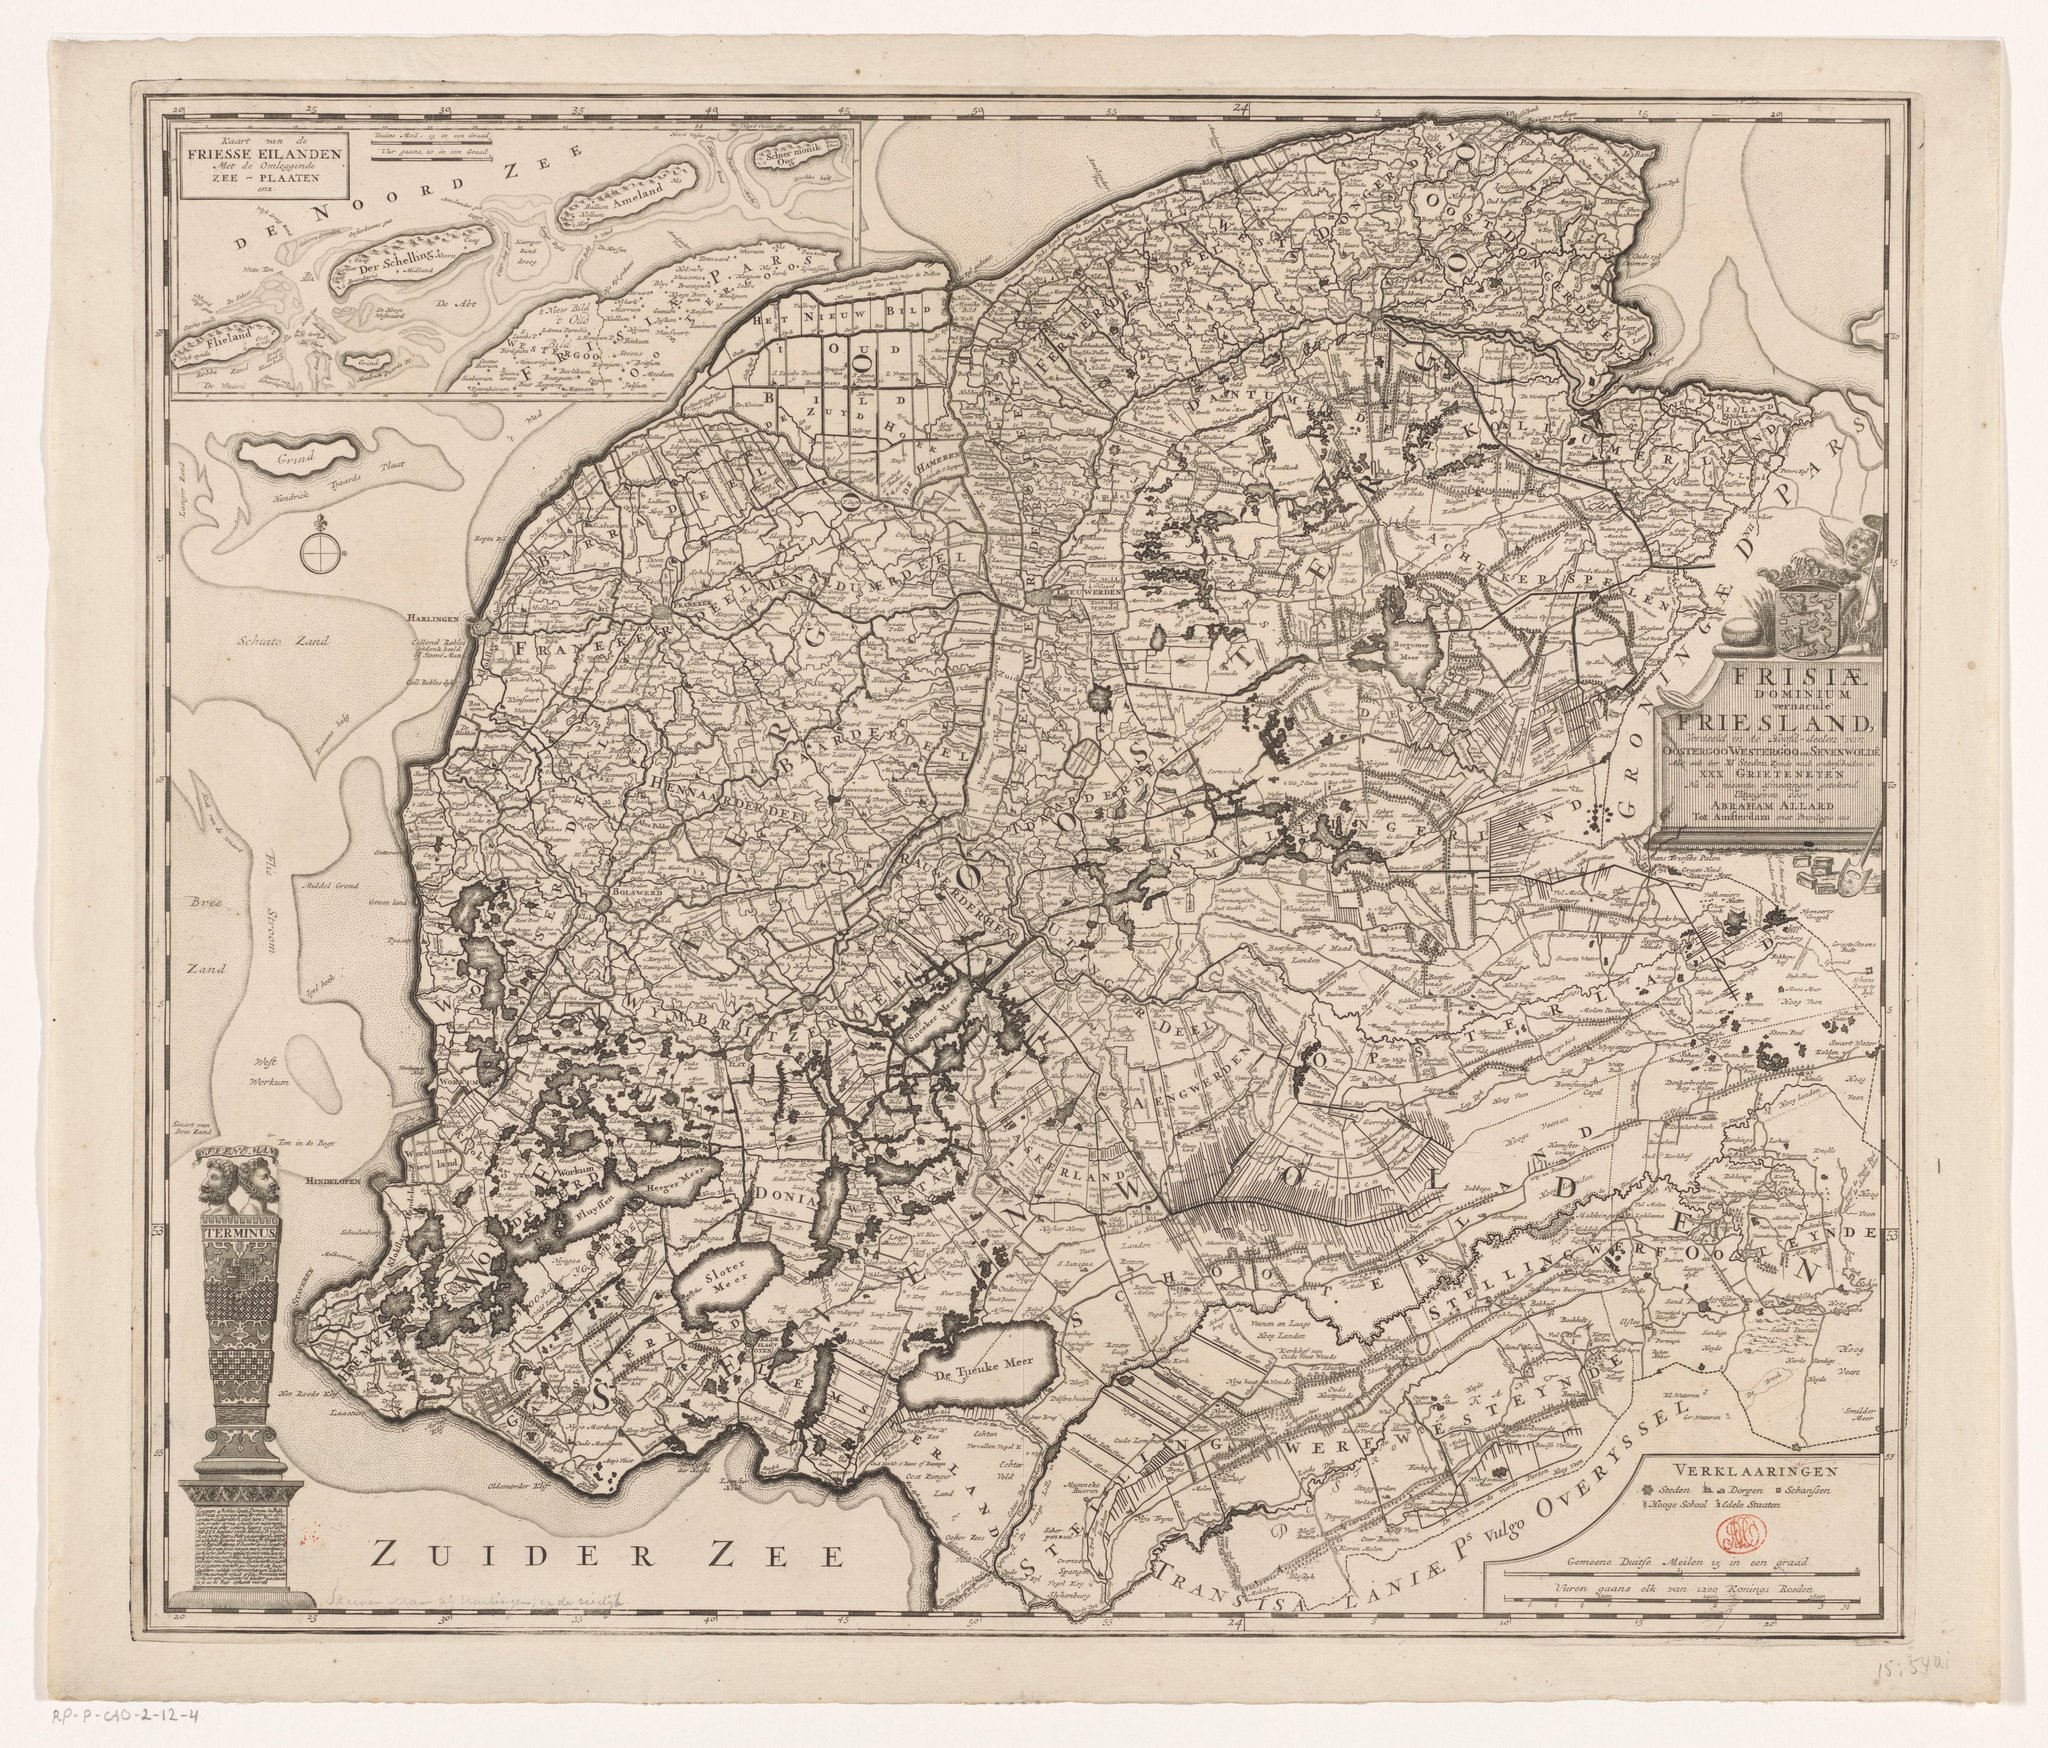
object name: print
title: Kaart van Friesland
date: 1703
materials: paper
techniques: engraving, etching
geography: amsterdam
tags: coat of arms (as symbol of the state, etc.), maps of separate countries or regions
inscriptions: collector's mark: Lugt 195, collector's mark: Lugt 2228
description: Linksboven inzetkaart van Vlieland, Terschelling, Ameland en Schiermonnikoog, met twee schaalstokken: Duitze meil 15 in een graad, Uur gaans 20 in een graad. Linksonder afbeelding van het standbeeld de Stenen Man te Harlingen. Rechtsmidden titelcartouche met daarboven het wapen van Friesland. Rechtsonder legenda en twee schaalstokken: Gemeene Duitse meilen 15 in een graad, Uuren gaans elk van 1200 konings roeden. Gradenverdeling langs de randen.